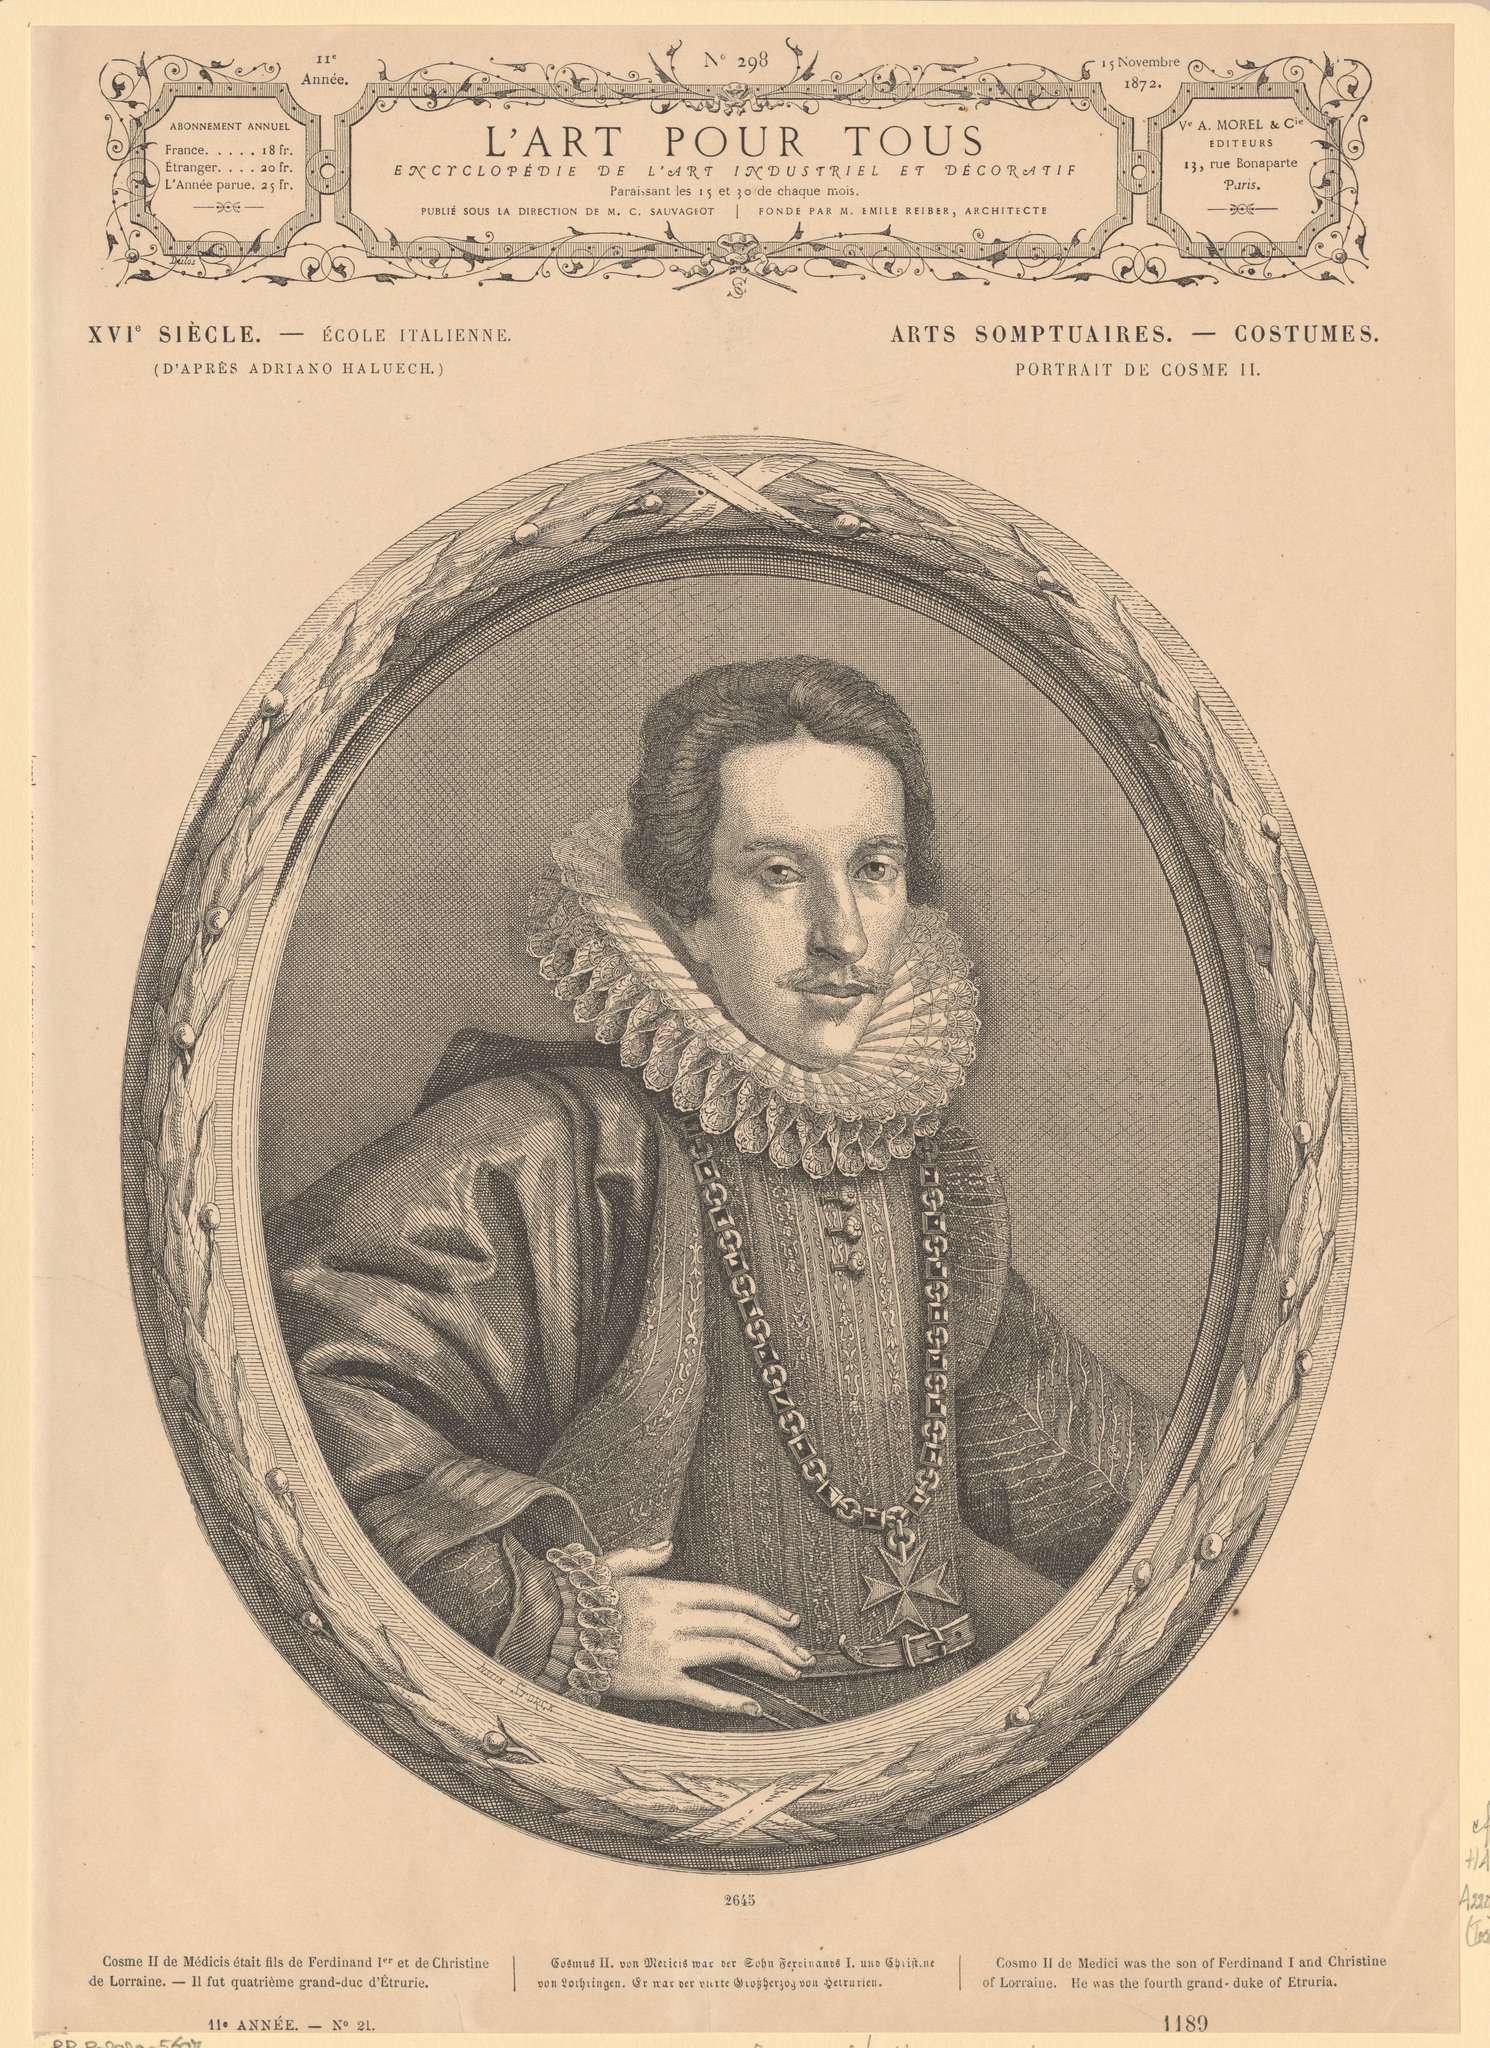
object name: photomechanical print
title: Portret van Cosimo II de' Medici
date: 1872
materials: paper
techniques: letterpress printing, printing block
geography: paris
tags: cosimo ii de' medici, historical persons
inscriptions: collector's mark: Lugt 3937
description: Prent uit: L'Art pour tous, nr. 298, 15 november 1872.